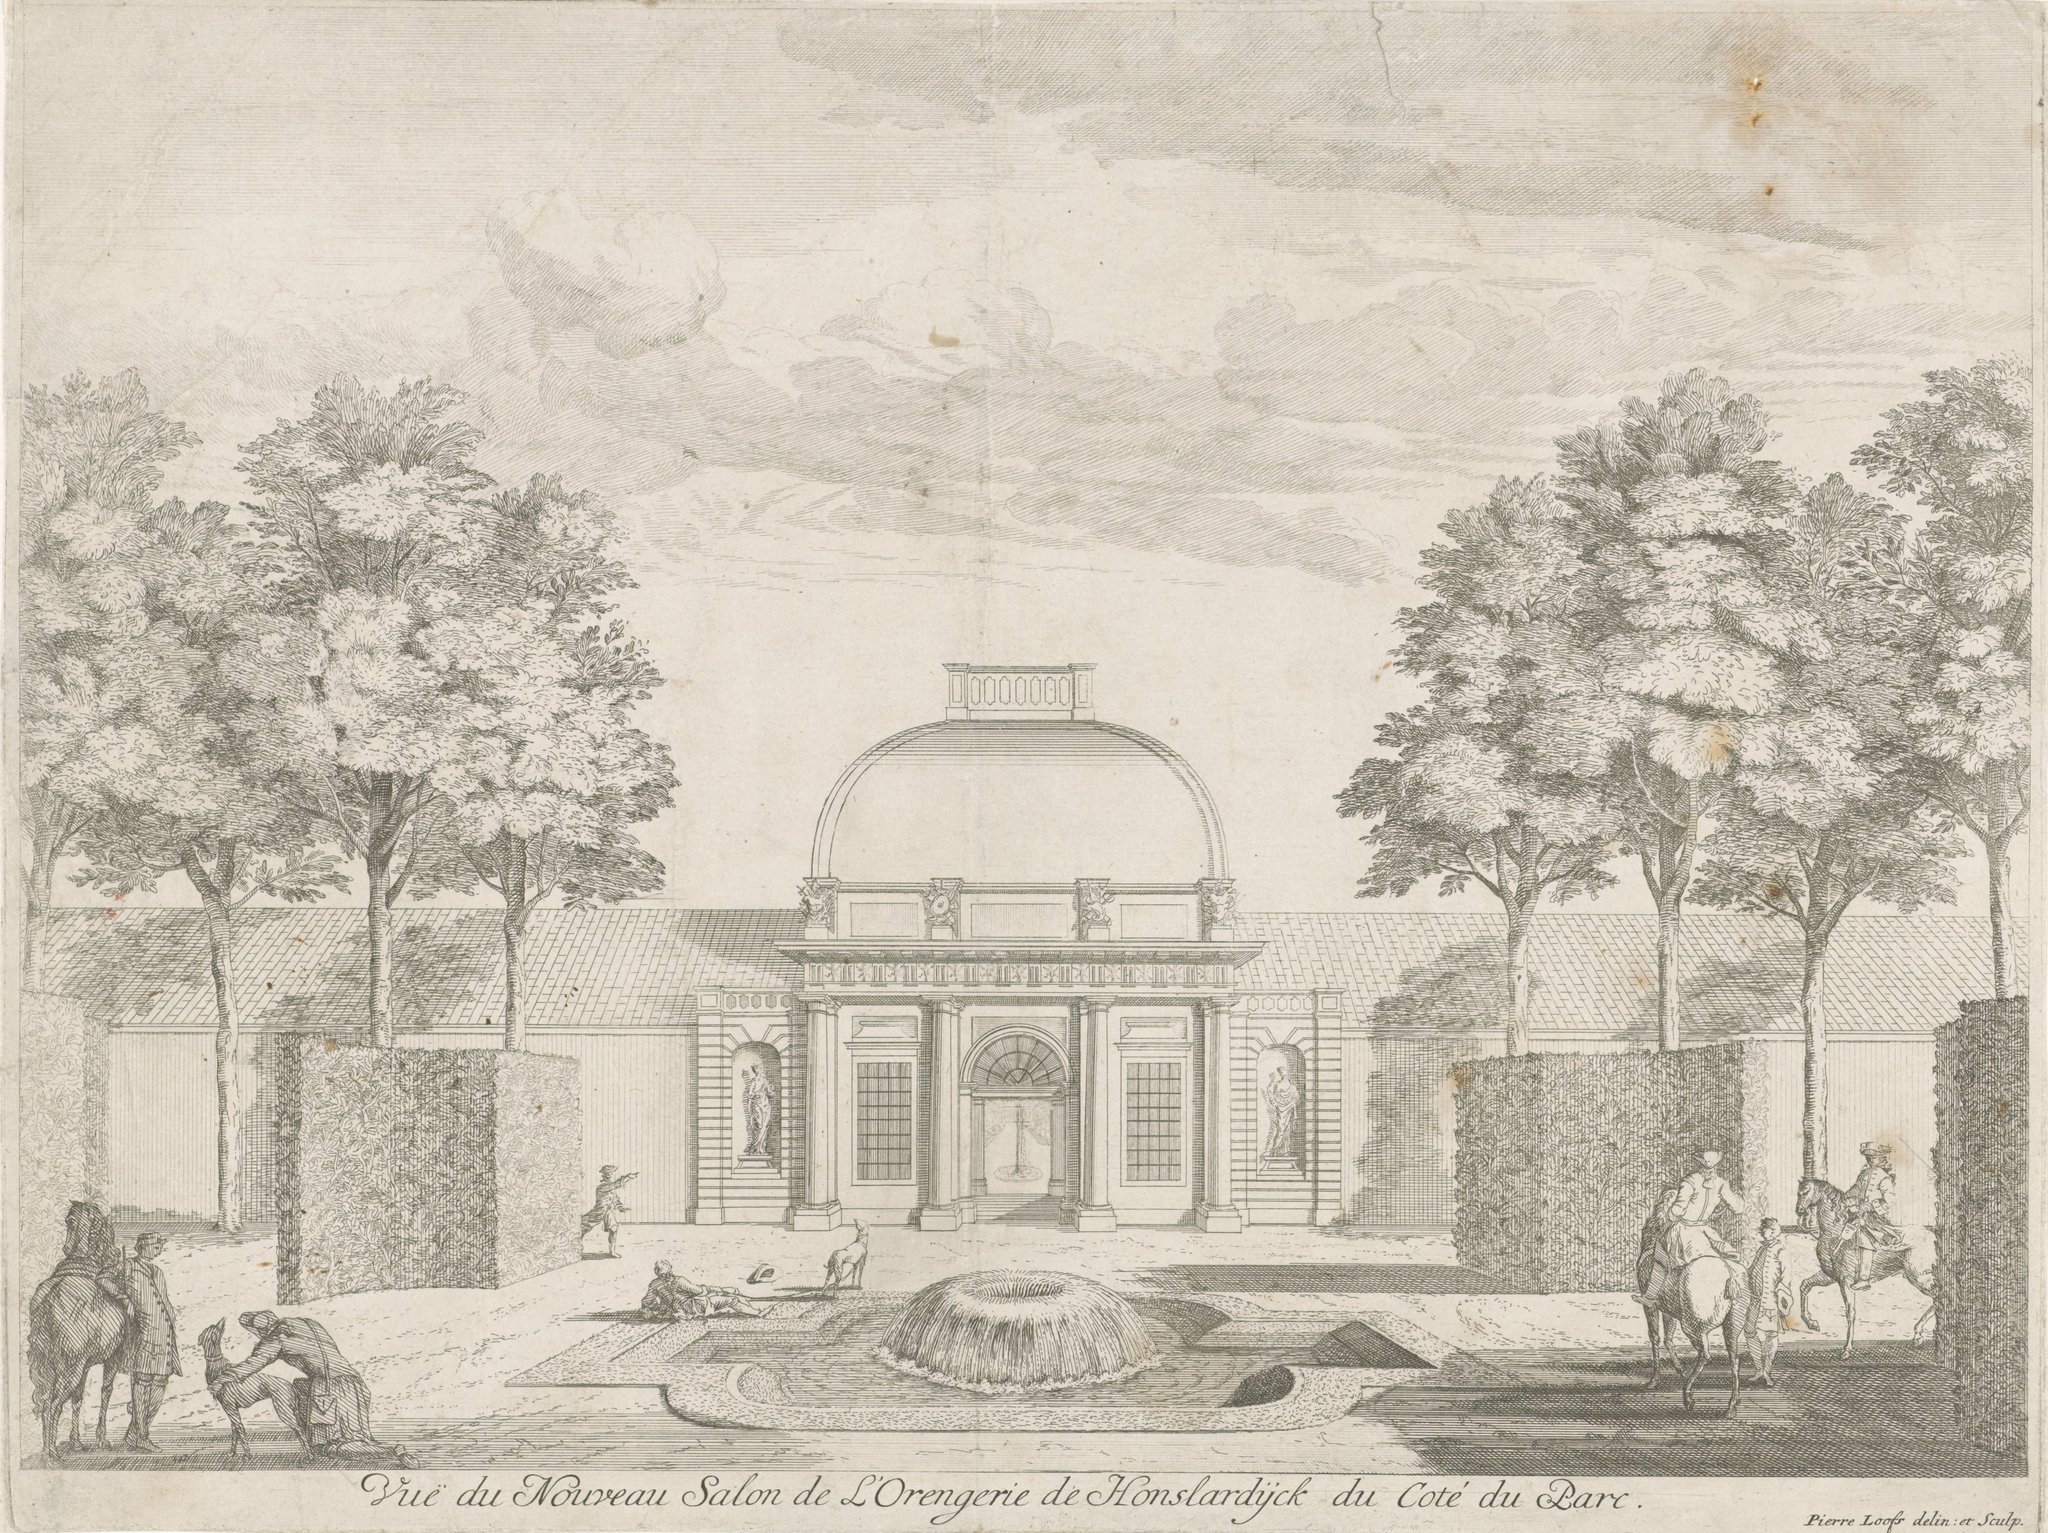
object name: print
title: Vue du Nouveau Salon de l'Orengerie de Honslardijck, du Coté du Parc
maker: pieter loofs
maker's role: print maker, publisher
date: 1713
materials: paper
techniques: etching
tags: garden fountain, greenhouse, orangery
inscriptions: collector's mark: Lugt 2228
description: De Oranjerie van Honselersdijk, gezien vanaf het park met fontein. Op de voorgrond figuren met paarden en honden.